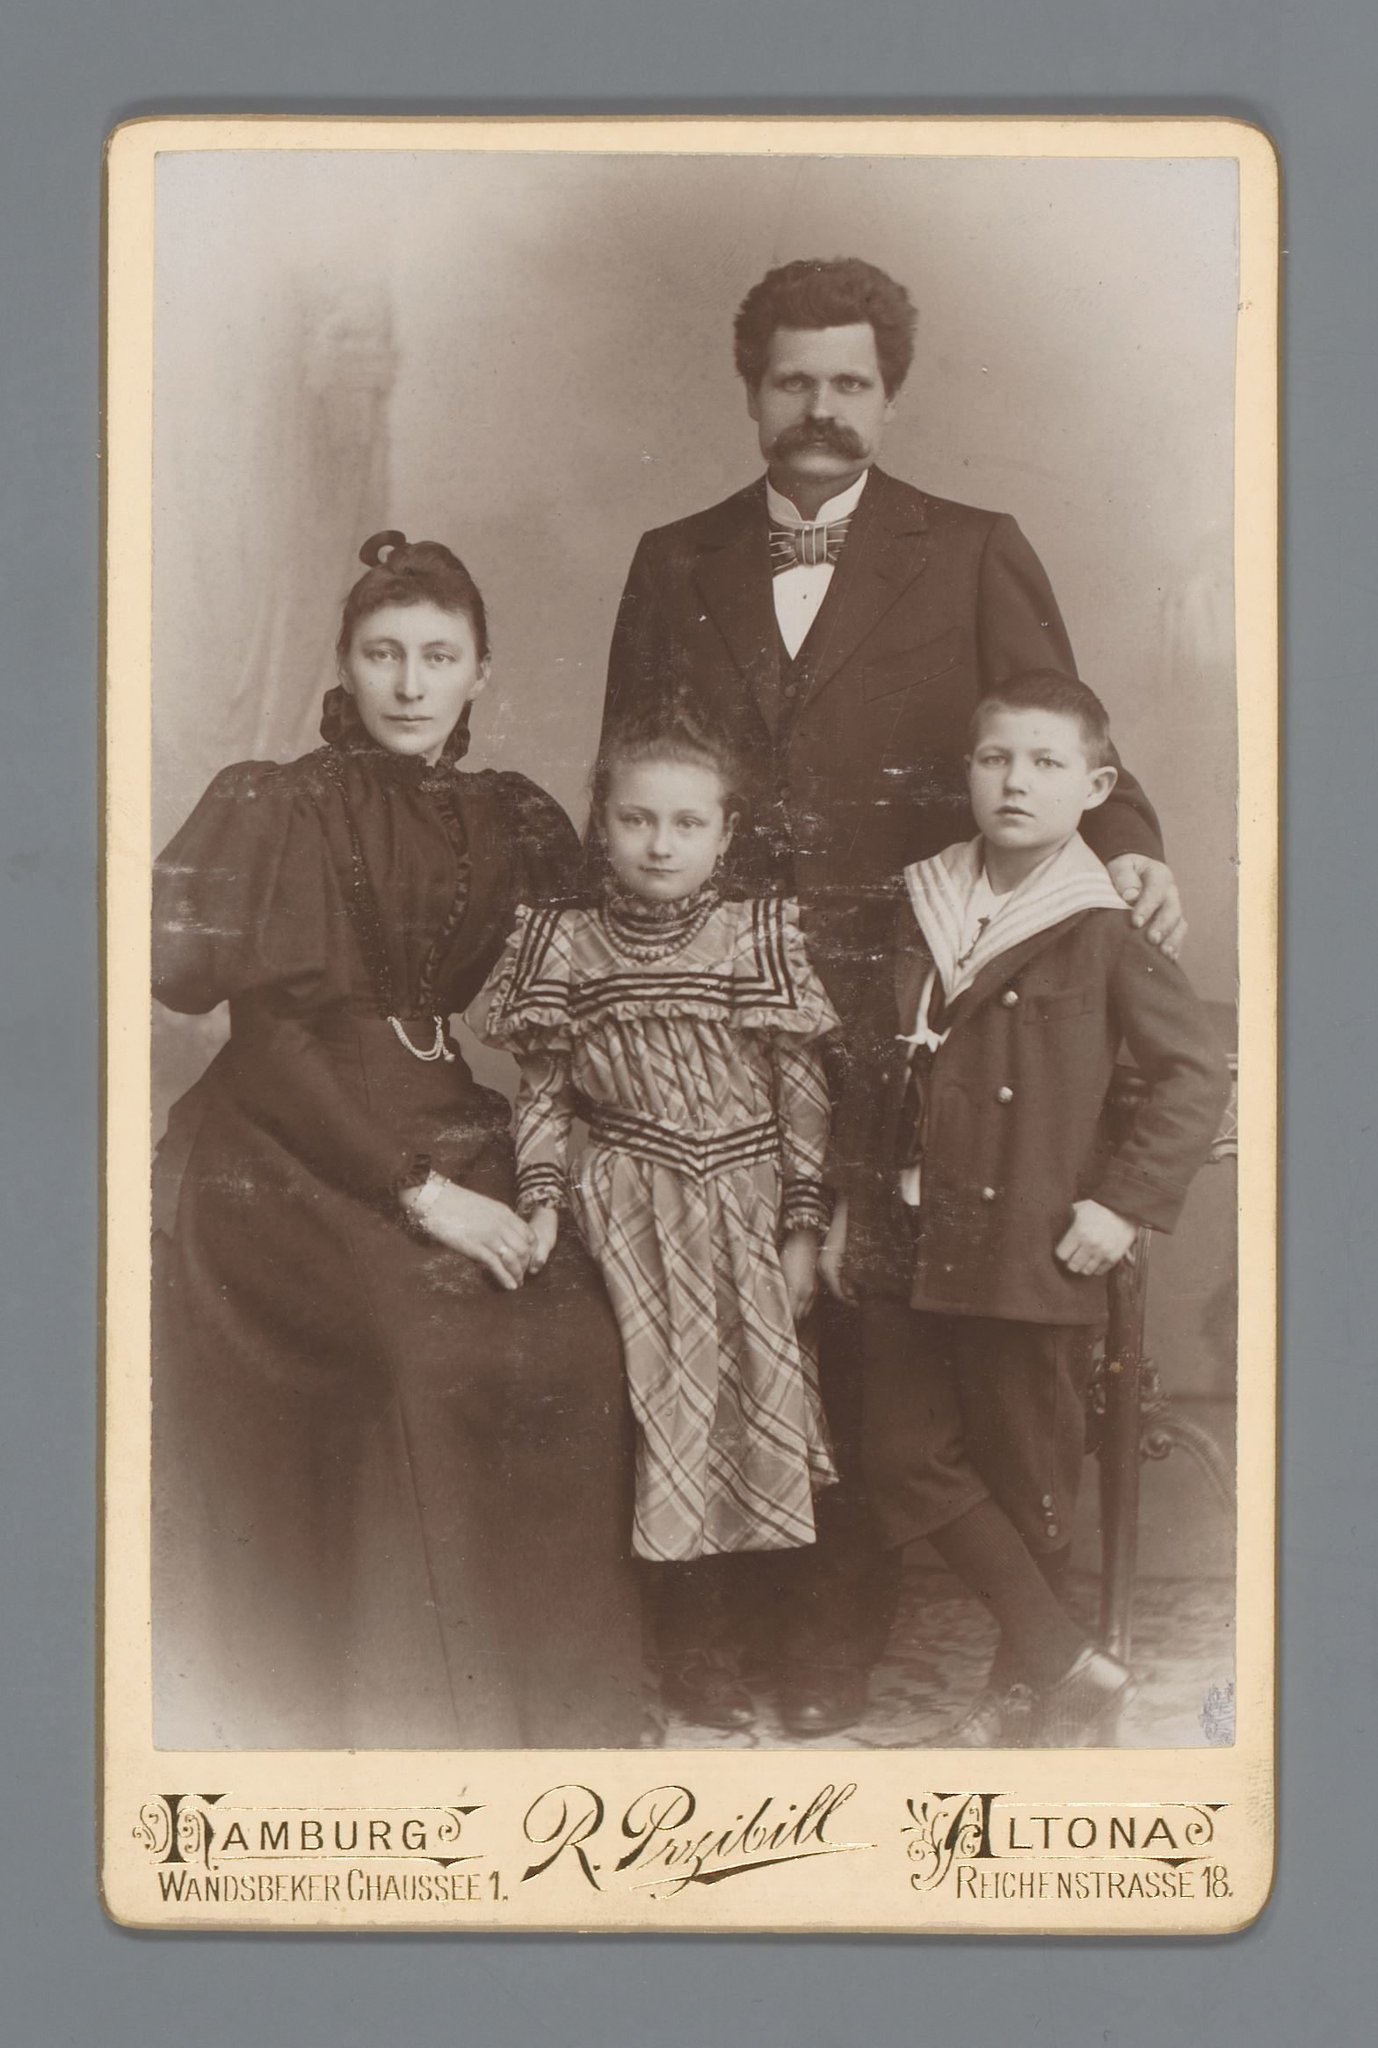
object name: photograph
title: Studioportret van een onbekend gezin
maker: r. przibill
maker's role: fotograaf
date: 1875-1890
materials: cardboard, photographic support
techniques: collodion silver print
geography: hamburg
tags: family group, especially parents with their child(ren)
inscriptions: name: ‘R. Przibill Hamburg Wandsbeker Chaussee 1. Altona Reichenstrasse 18.’